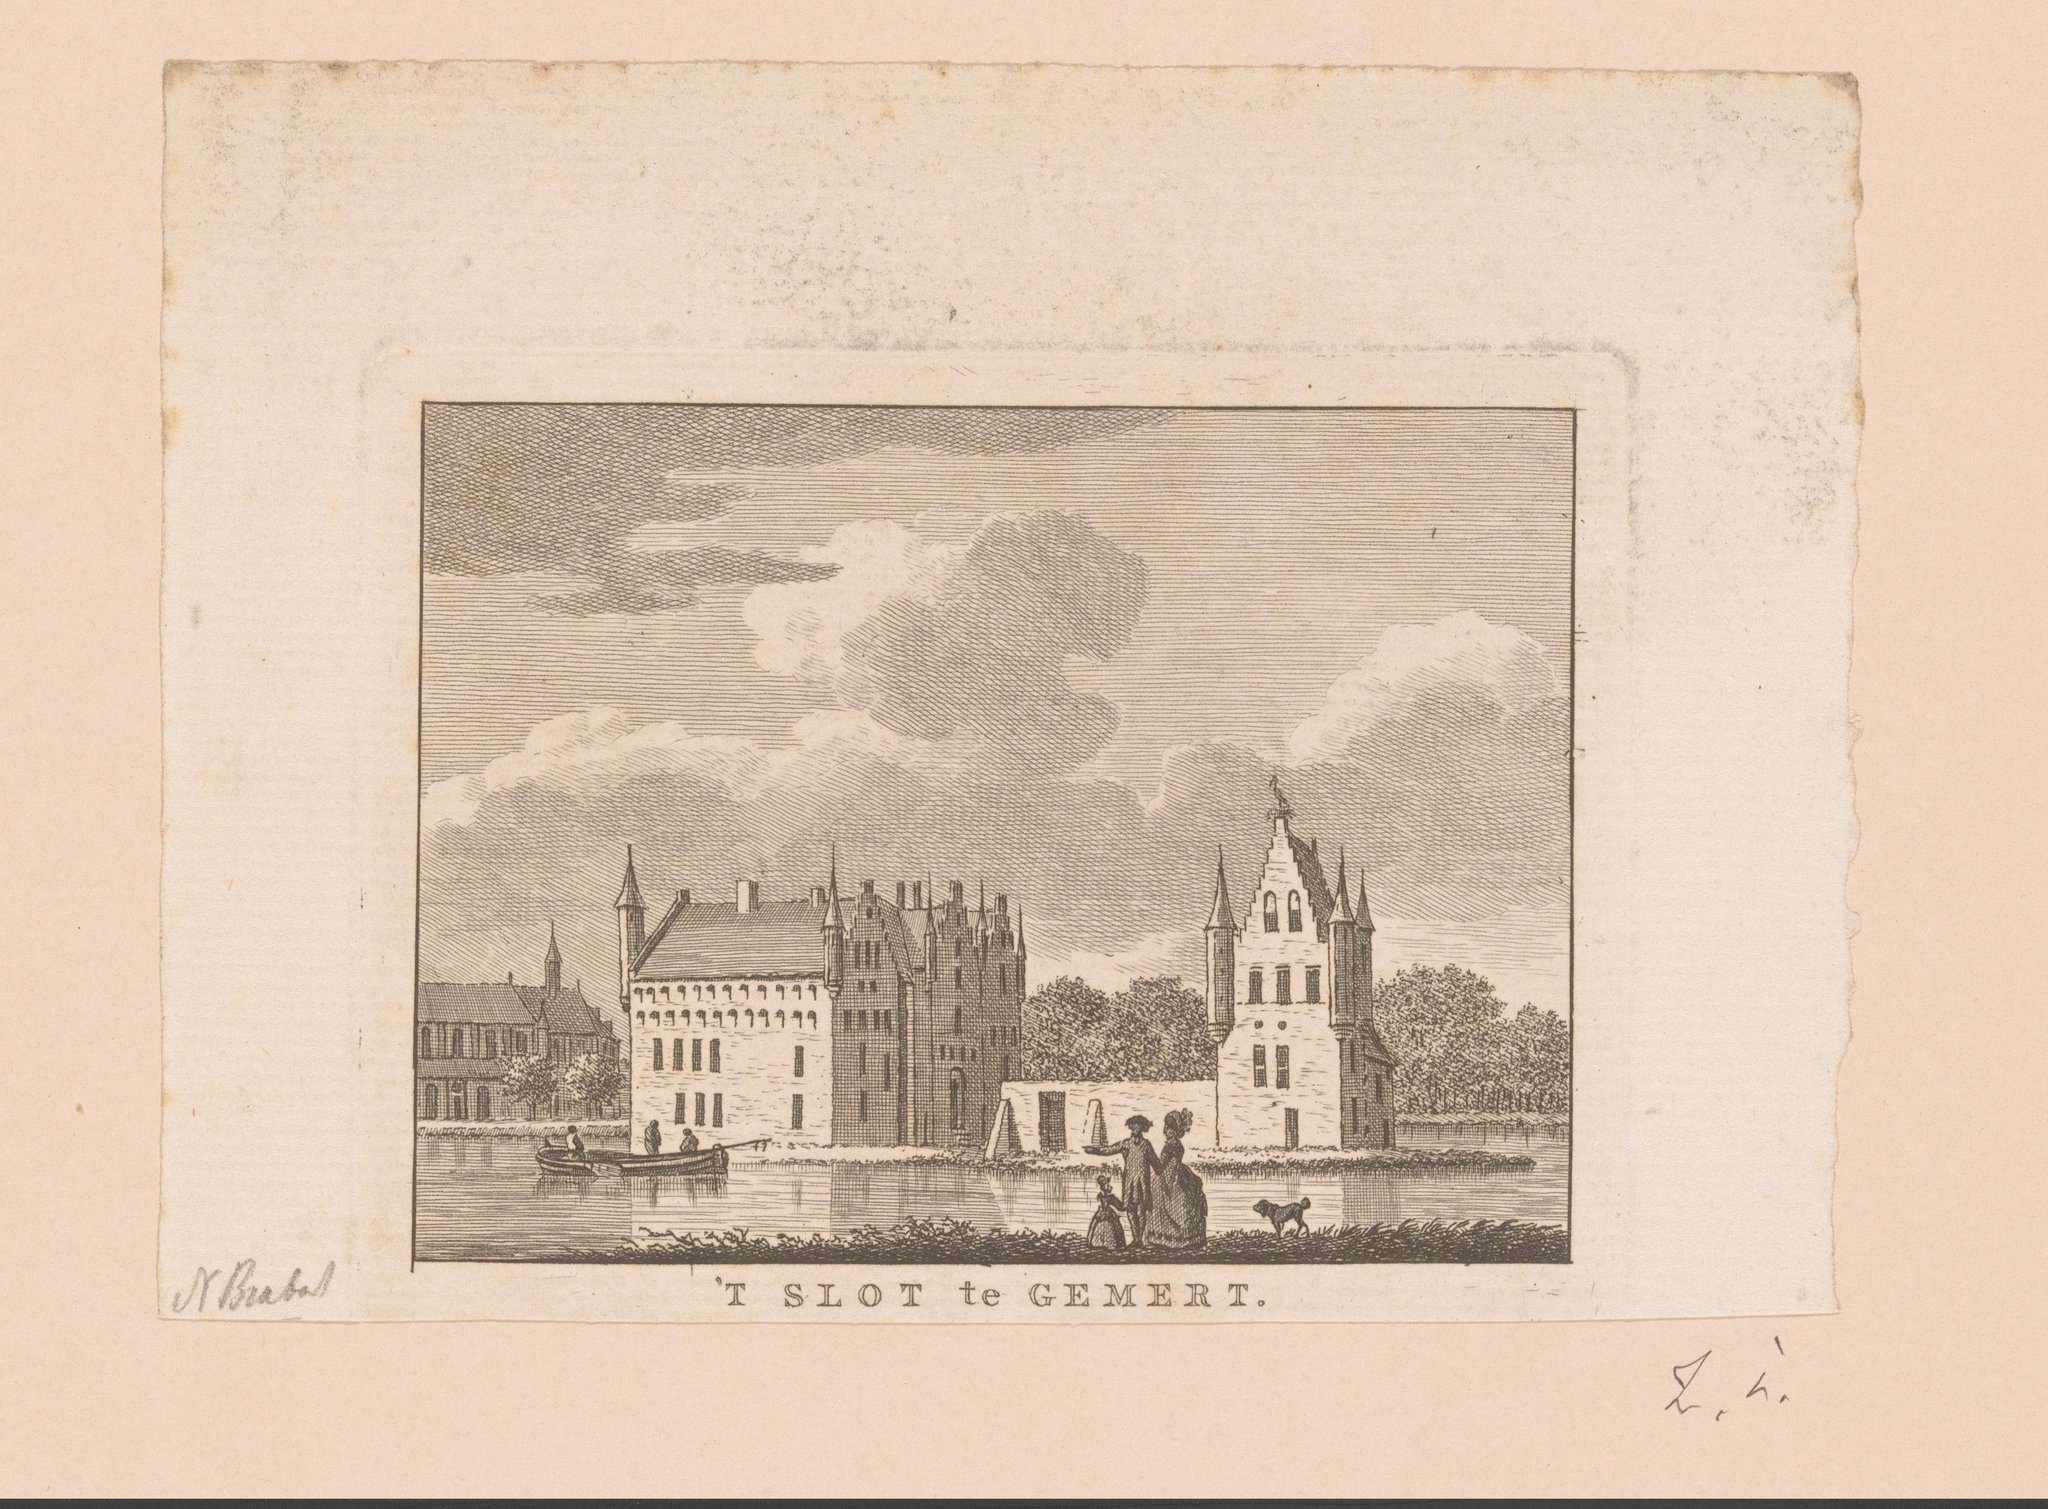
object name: print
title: Gezicht op het Kasteel van Gemert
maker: carel frederik bendorp (i)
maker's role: print maker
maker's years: 1736-1814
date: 1786-1792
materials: paper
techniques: engraving, etching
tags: castle, landscape with tower or castle, gemert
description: Prent uit: Vaderlandsche gezichten, of afbeeldingen van den tegenwoordigen staat der Vereenigde Nederlanden (…). Amsterdam: Hendrik Gartman, Willem Vermandel en Jan Willem Smit, 1786-1792. Uitgegeven in afleveringen met ieder een eigen bifolium en inhoudsopgave. Alle prenten in deze publicatie zijn gegraveerd door Carel Frederik Bendorp (I) en, in de meeste gevallen, gebaseerd op tekeningen van Jan Bulthuis.